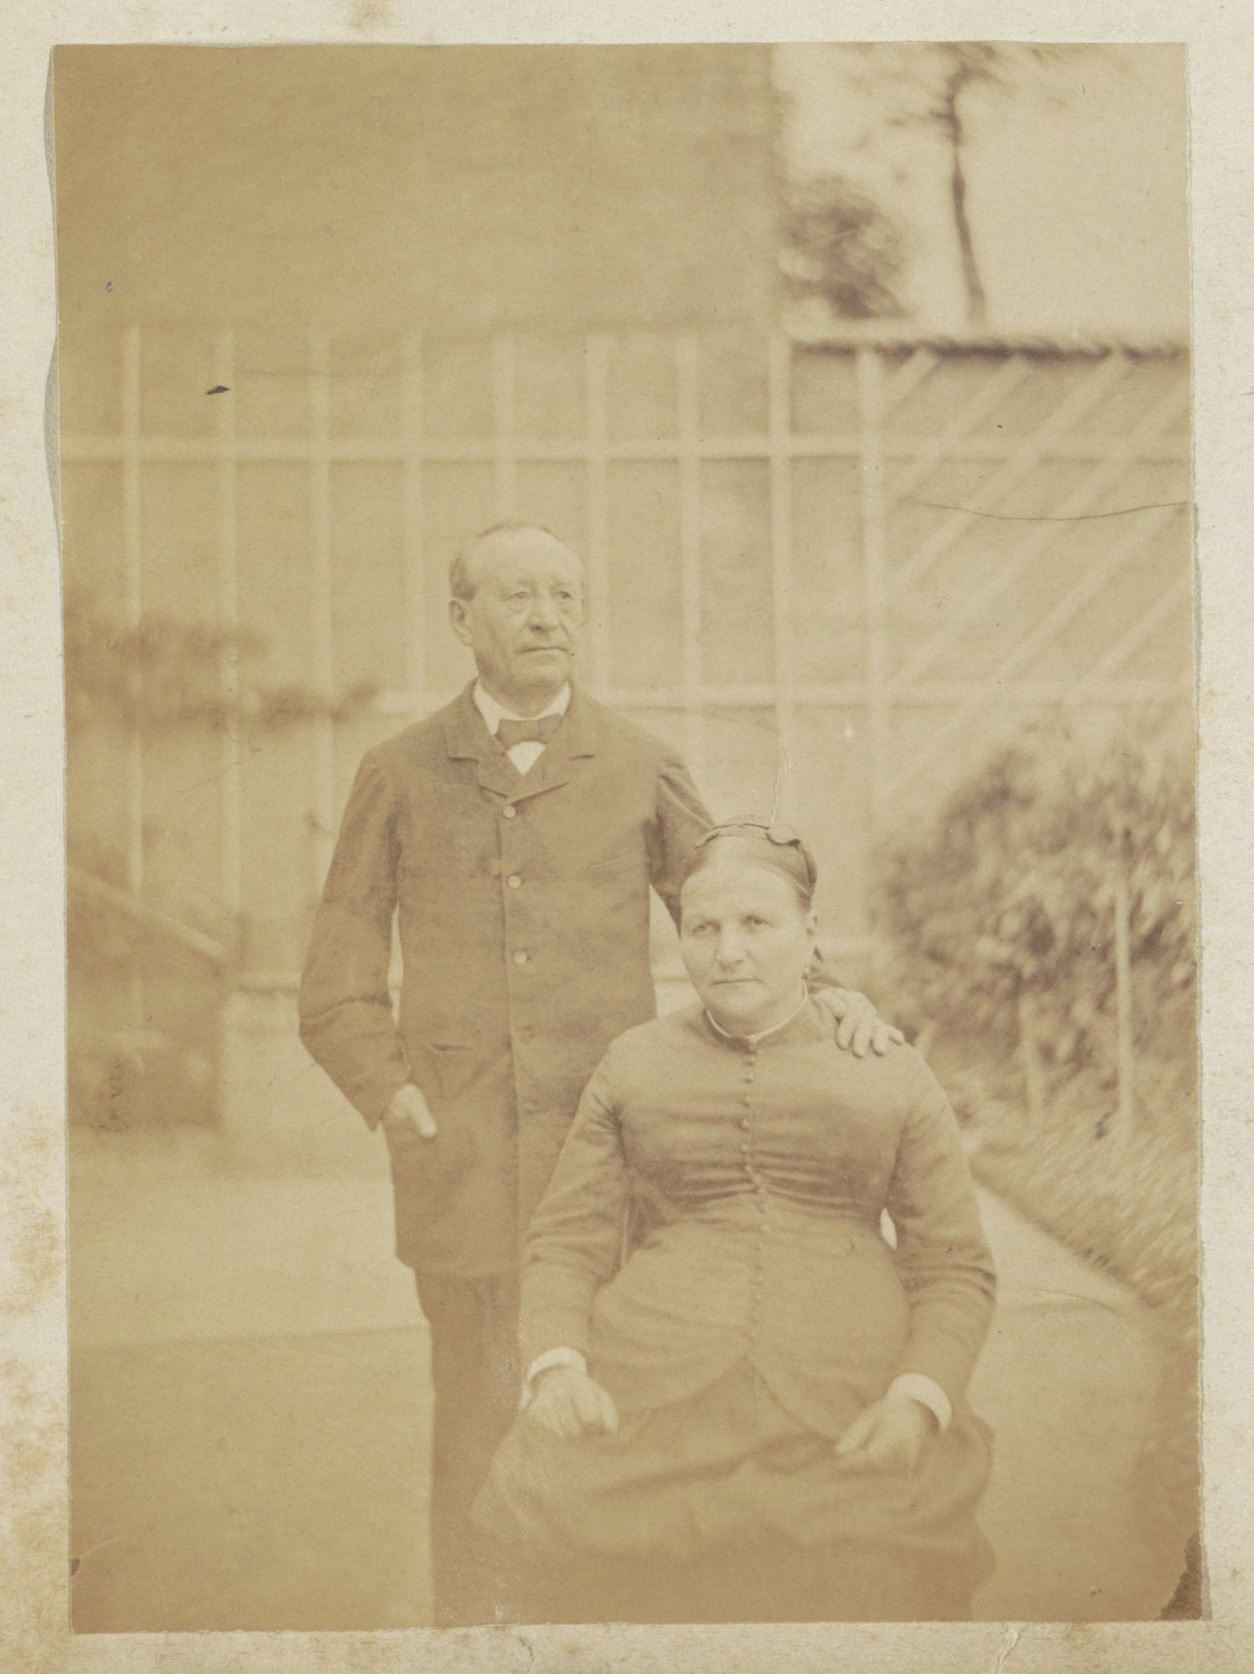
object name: photograph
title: Portret van een Frans stel, de vrouw zittend, de man staand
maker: Anonymous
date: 1805-1884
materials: photographic support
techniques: albumen print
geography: france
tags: marriage, married couple, 'matrimonium'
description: Onderdeel van Album van een Franse amateurfotograaf met opnames van familie, militairen, industrie, landschappen en bezienswaardigheden in Frankrijk.